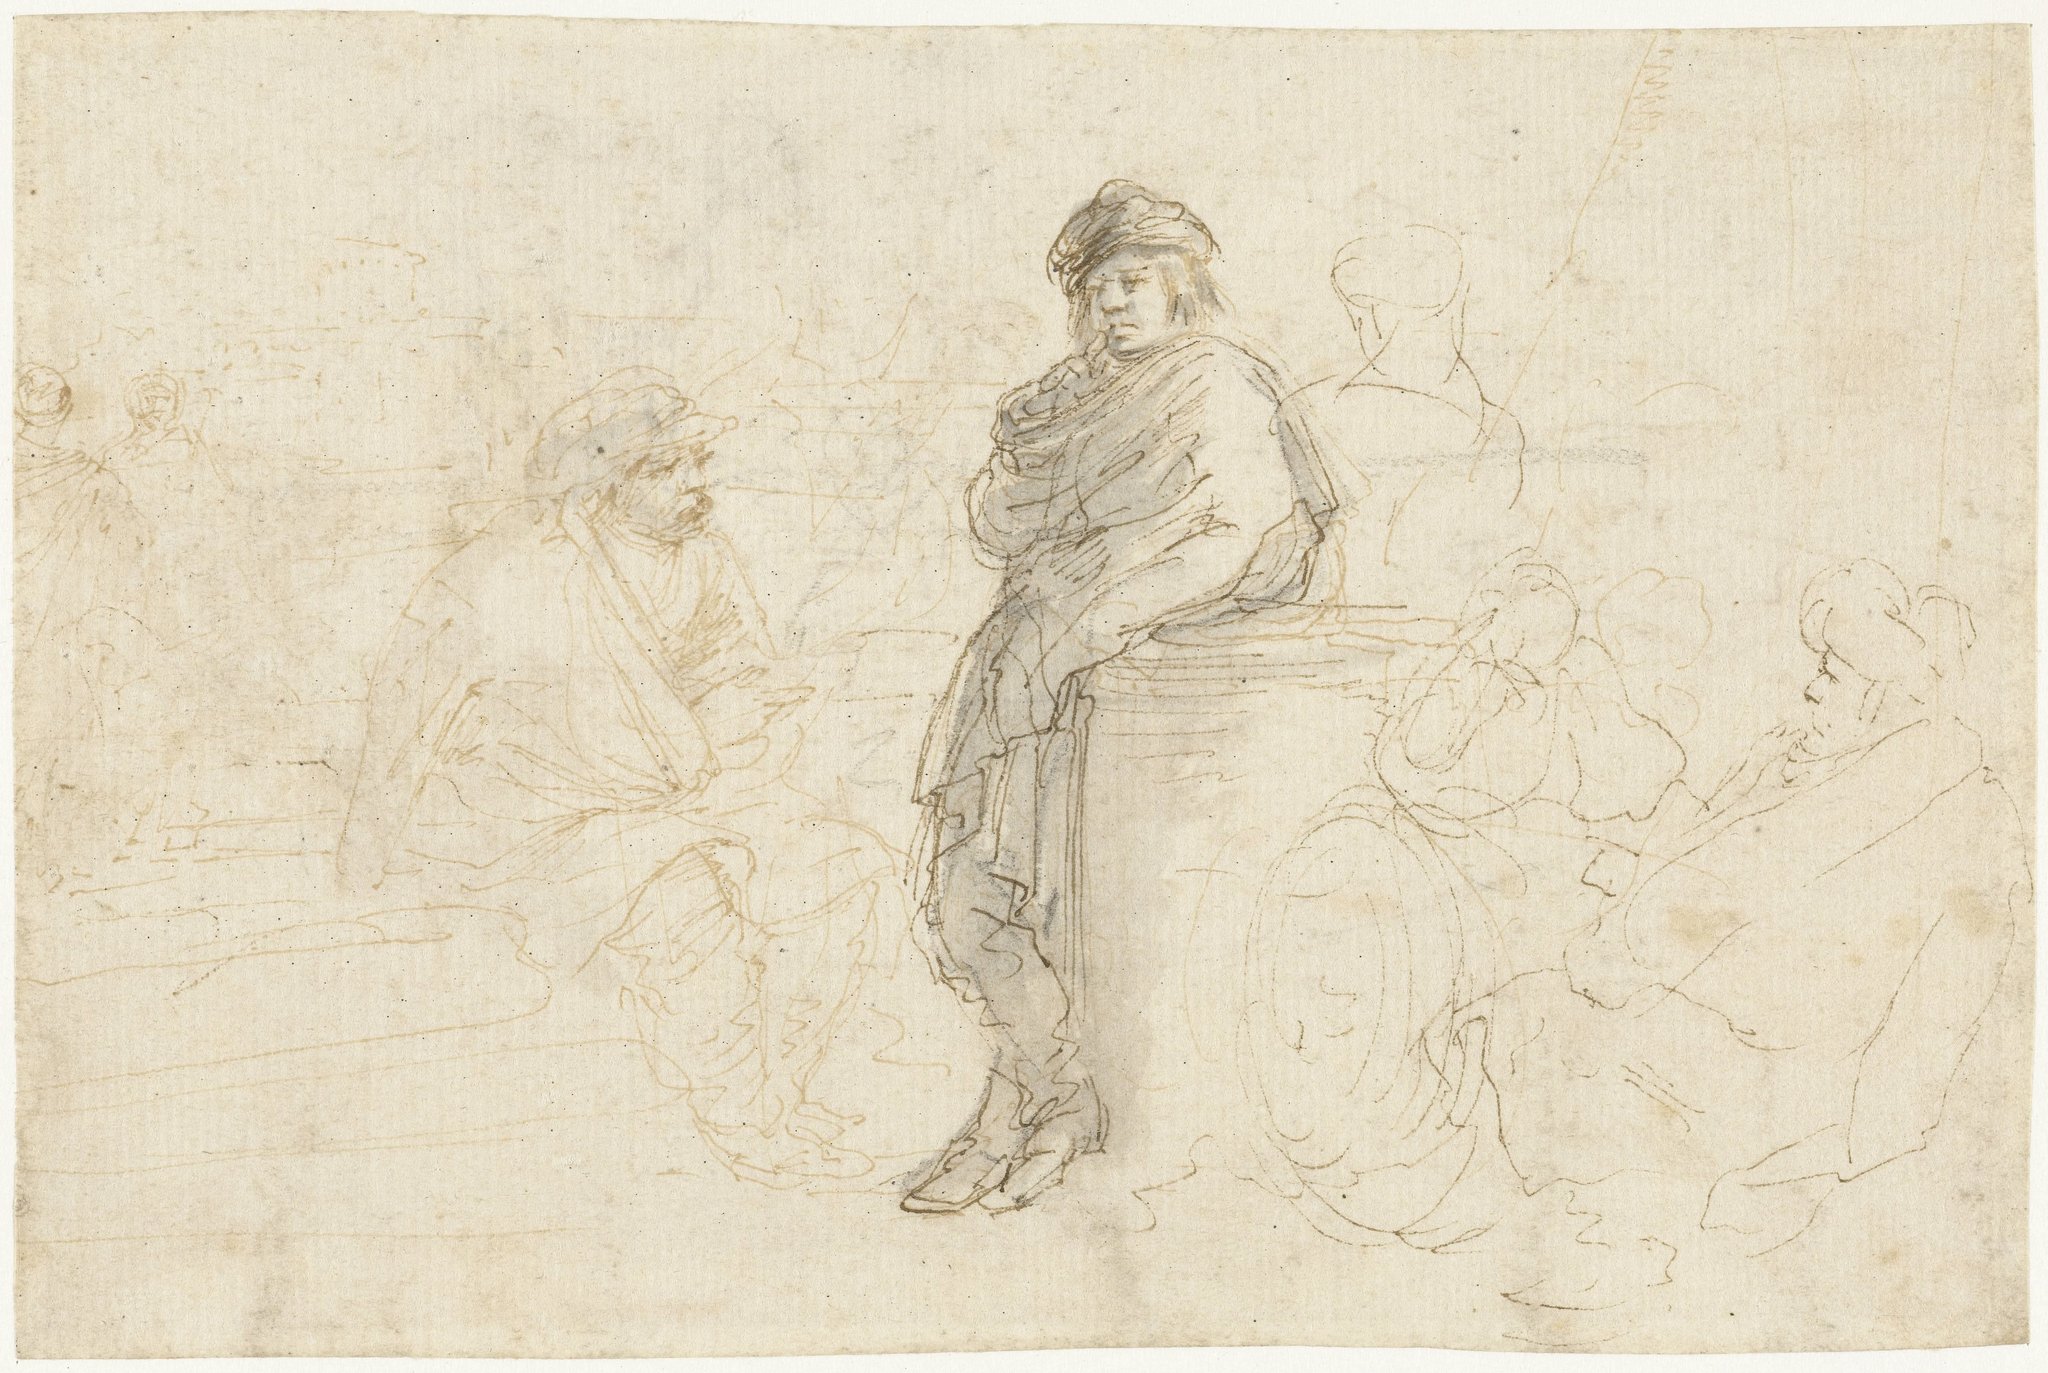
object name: drawing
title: Wachtende oosterlingen op een kade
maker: stefano della bella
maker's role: draughtsman, print maker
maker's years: 1610-1664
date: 1644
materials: ink, paper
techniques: brush, pen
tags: pier, quay, wharf, quay (+ city(-scape) with figures, staffage)